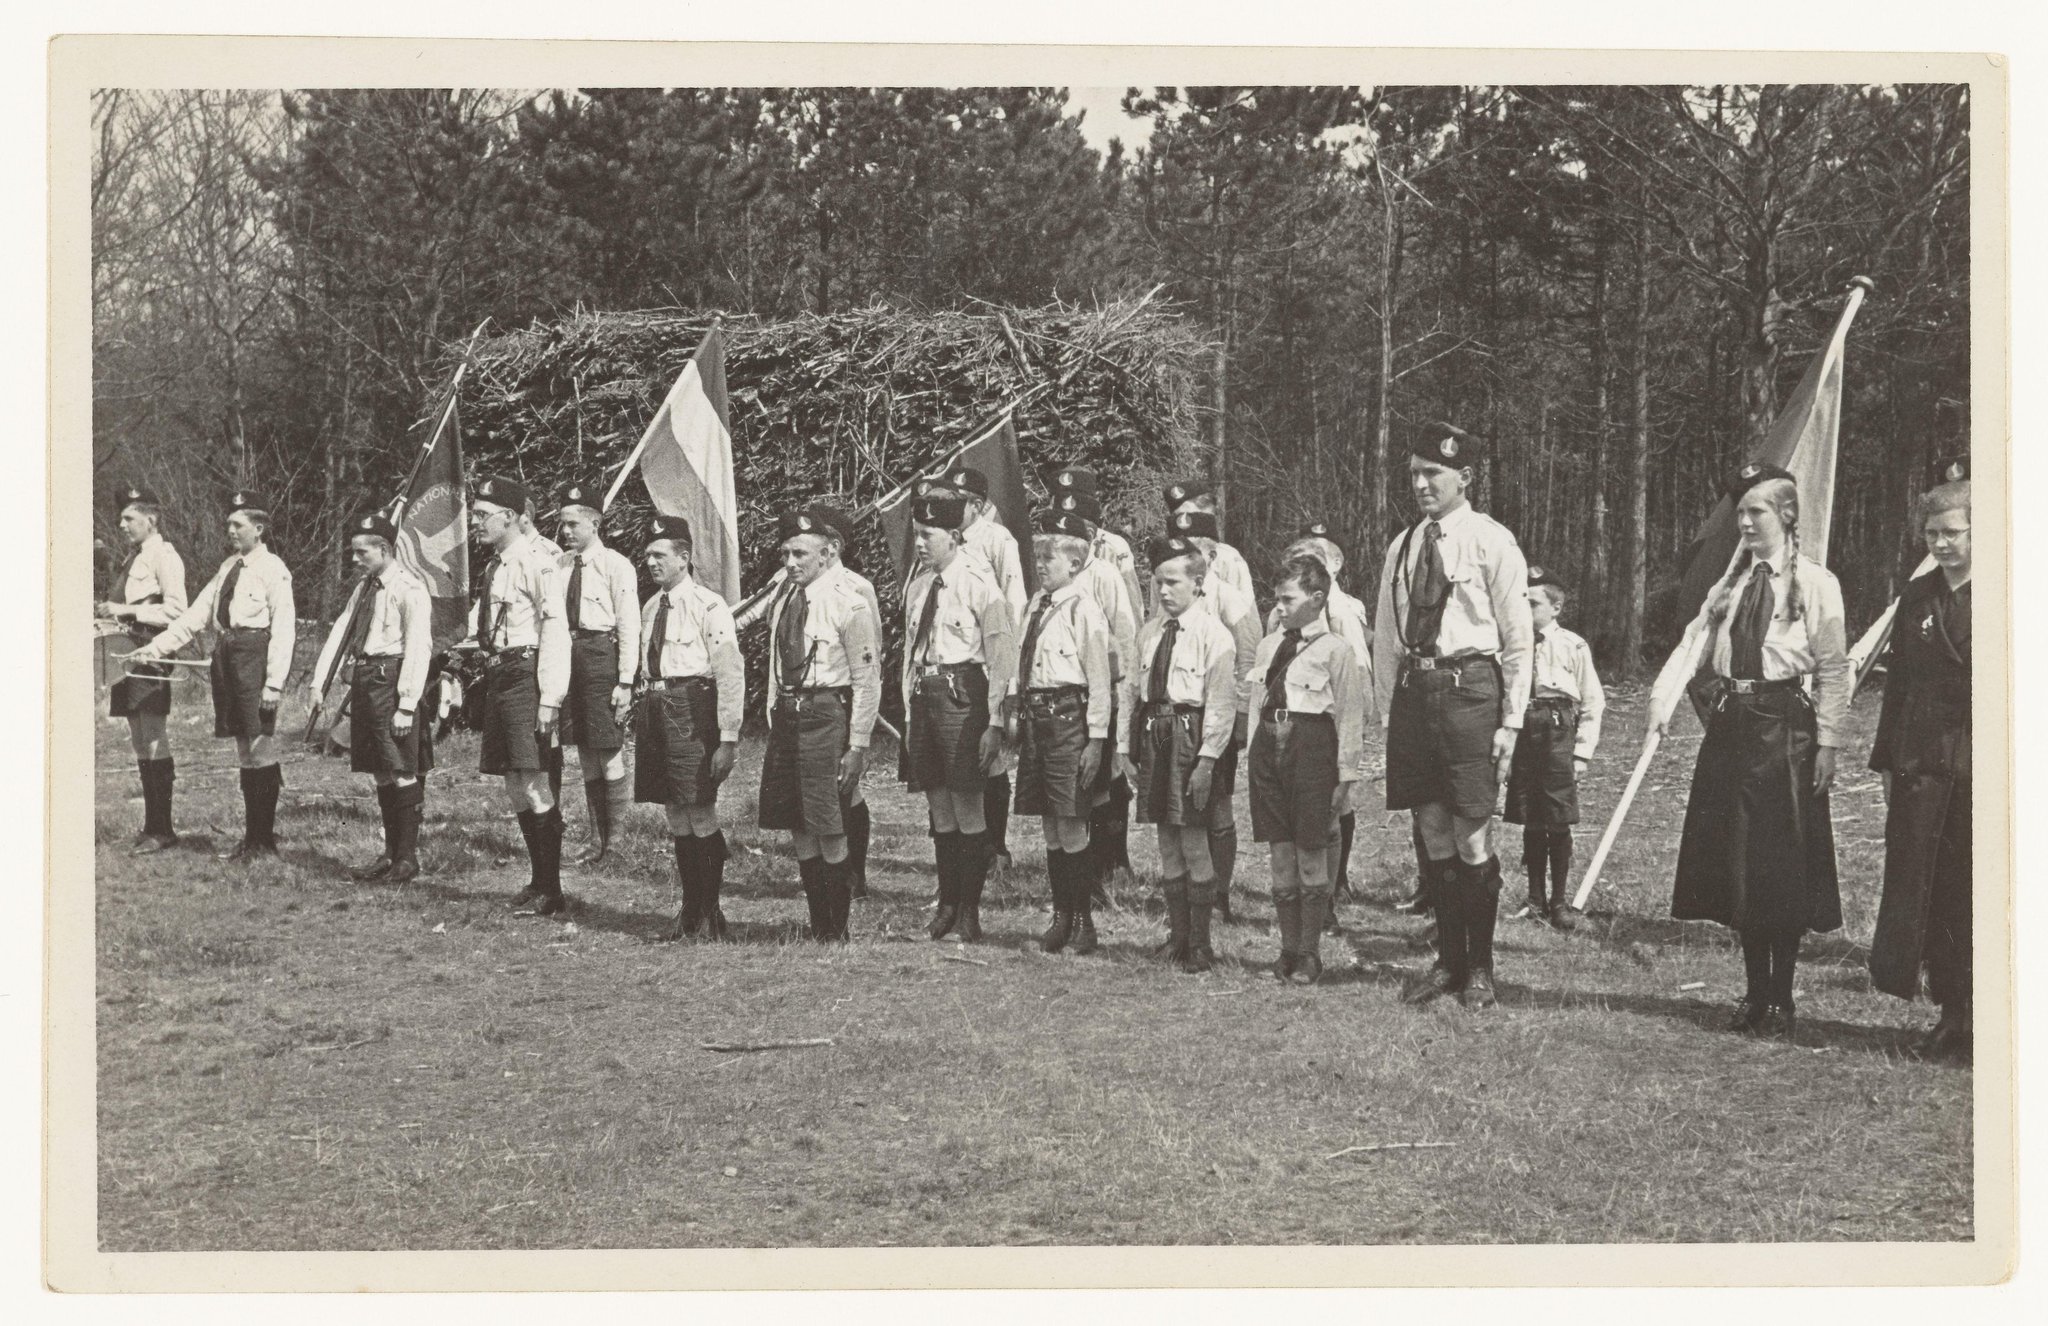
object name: photograph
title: Na afloop van de optocht Jeugdstorm: in de rij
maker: j. otto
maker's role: fotograaf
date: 1935-1937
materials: photographic support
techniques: gelatin silver print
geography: zeist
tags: military parade, pageant, zeist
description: In een bosachtige omgeving staan leden van de Jeugdstorm in uniform in het gelid in twee rijen, vermoedelijk na afloop van de optocht. Links twee jongens met trompetten, rechts een meisje met een vlag. In het midden zijn nog drie vlaggen te zien. Op de achtergrond een hoge houtstapel.